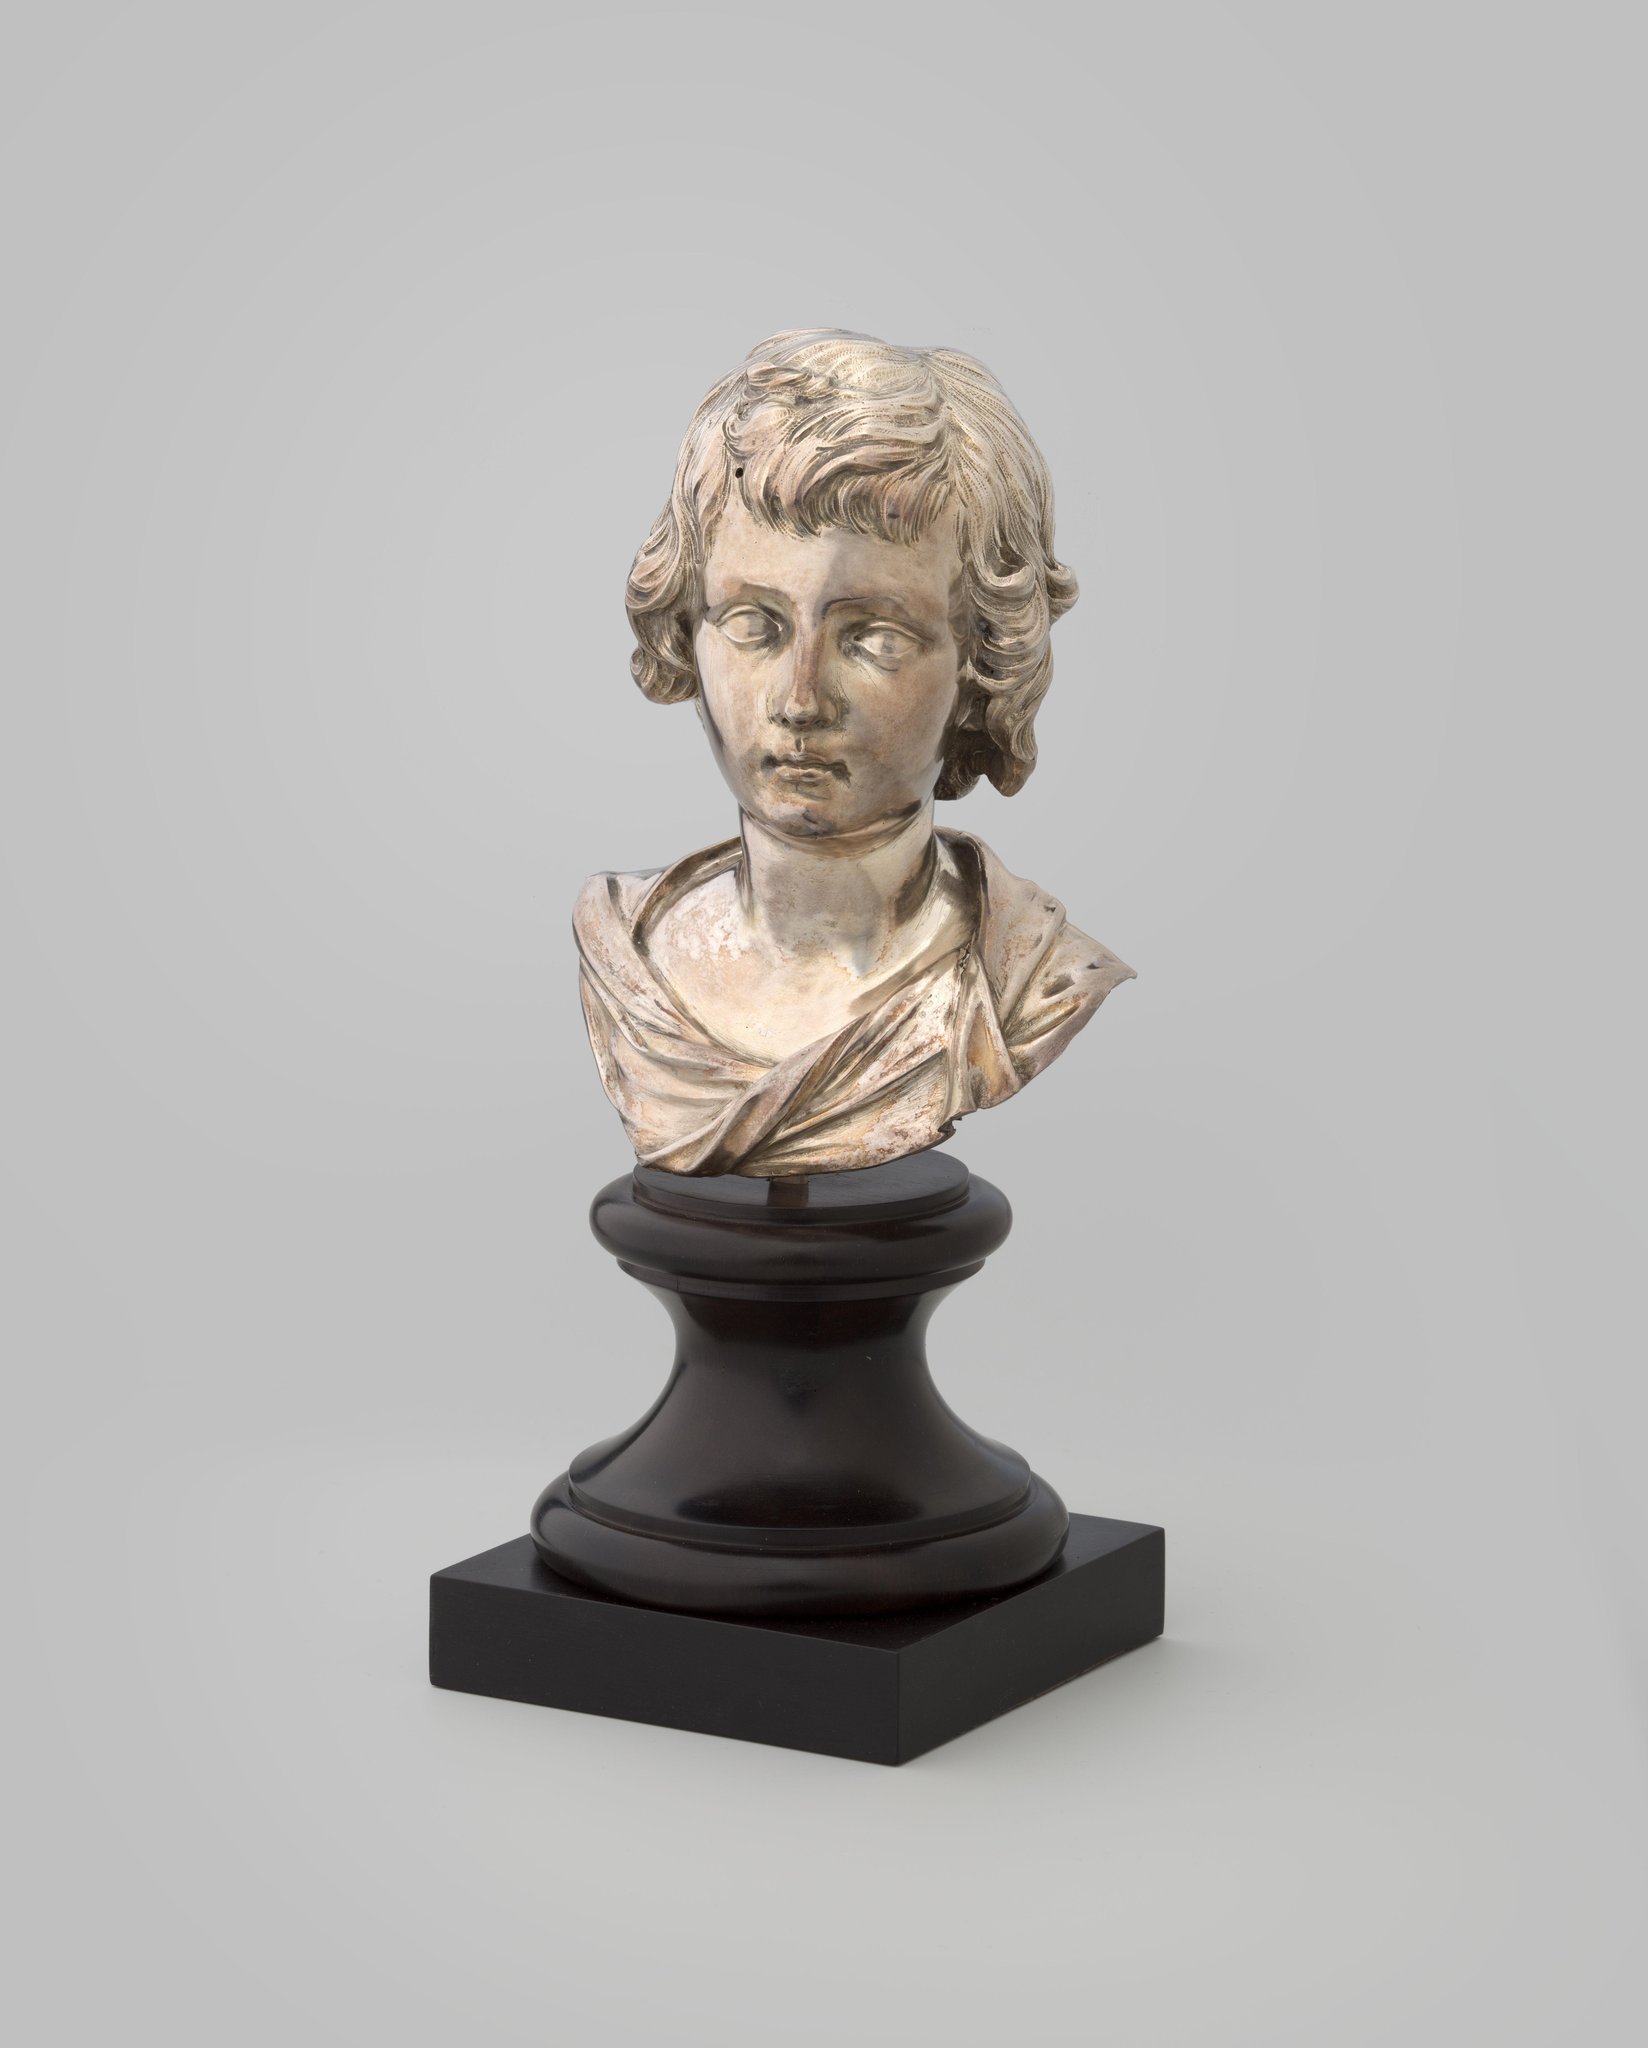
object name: sculpture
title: Jezus als jongeling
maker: françois du quesnoy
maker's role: draughtsman, sculptor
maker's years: 1597-1643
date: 1630-1650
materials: silver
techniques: casting, metalworking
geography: rome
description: Kleine buste (bustino) van de jonge Jezus all'antica met kort haar en zonder baard, en een mantel die licht asymmetrisch om zijn schouders is gedrapeerd. Het gezicht is licht zijwaarts gedraaid en heeft een serieuze, om niet te zeggen trieste uitdrukking die vooruitwijst naar zijn kruisdood op Golgotha. De oogballen zijn onbewerkt gelaten, waardoor de klassieke uitstraling van de buste wordt versterkt. De haren zijn met een kleine pons geciseleerd.